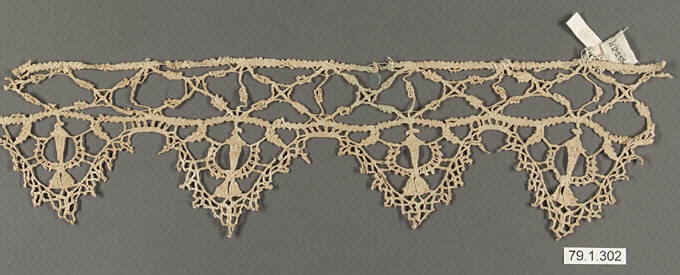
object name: piece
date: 1600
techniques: lace